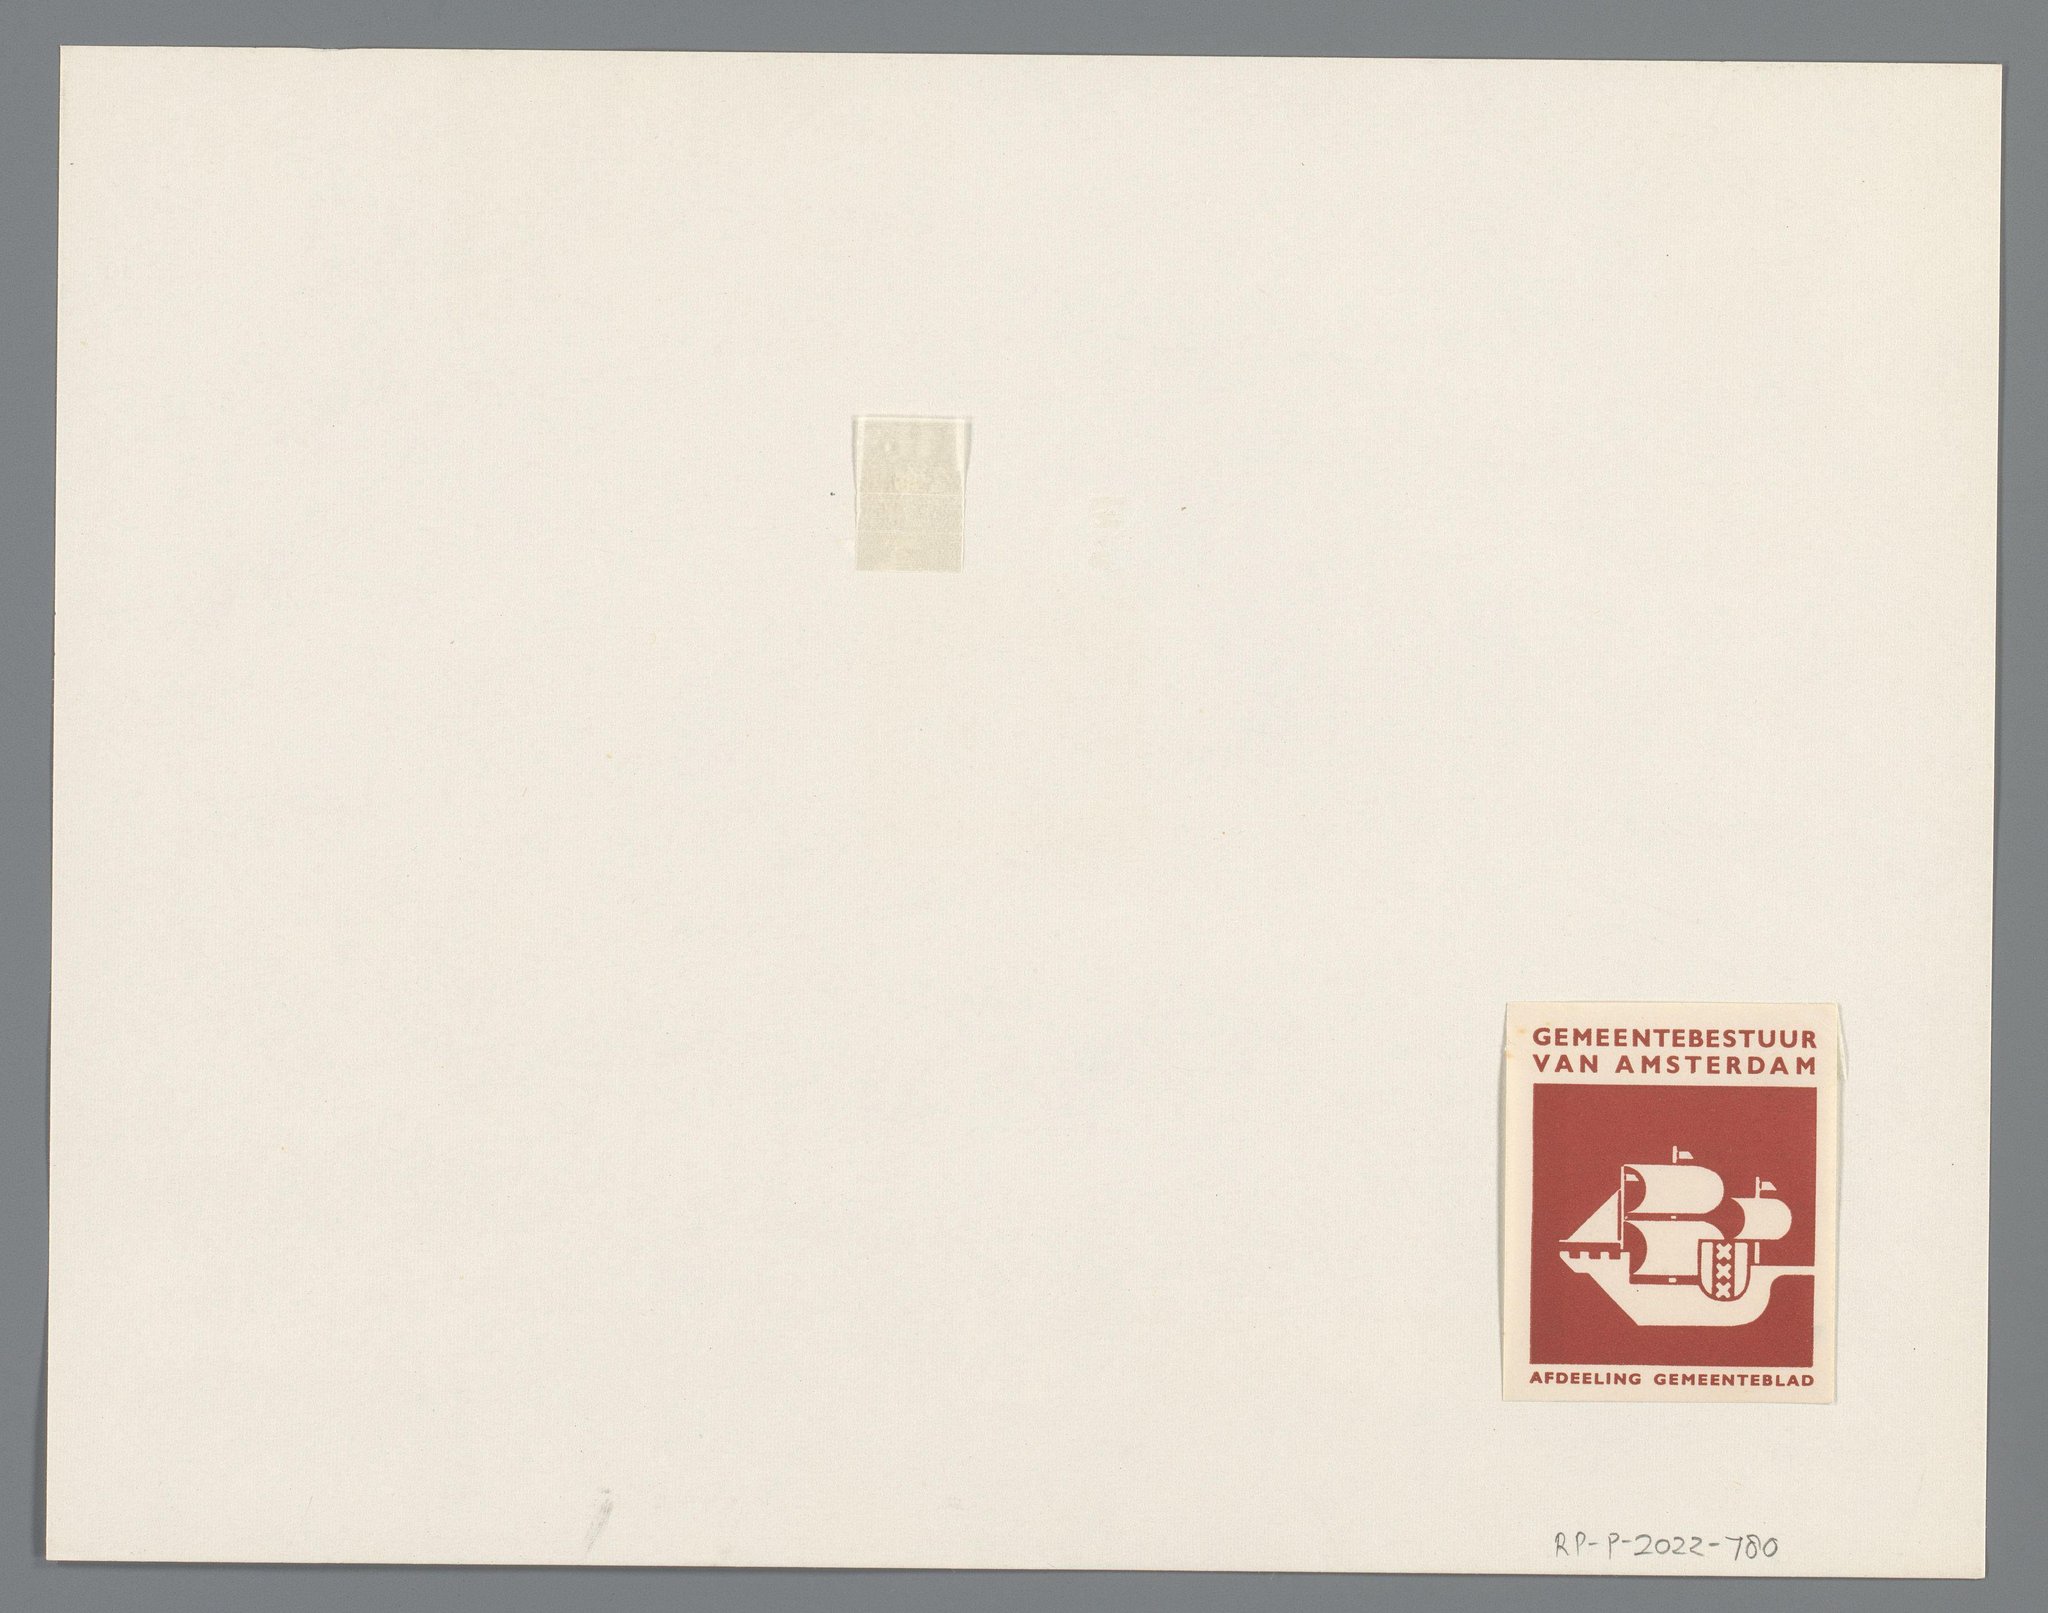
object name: vignette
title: Sluitzegel Gemeentebestuur van Amsterdam / Afdeeling Gemeenteblad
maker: Anonymous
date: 1920-1950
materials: gum, paper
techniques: offset printed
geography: netherlands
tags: coat of arms (as symbol of the state, etc.) (+ city; municipal), sailing-ship, sailing-boat, trade mark, trade token, trade sign, trade card, amsterdam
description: Sluitzegel Gemeentebestuur van Amsterdam / Afdeeling Gemeenteblad: zeilschip met het stadswapen van Amsterdam.